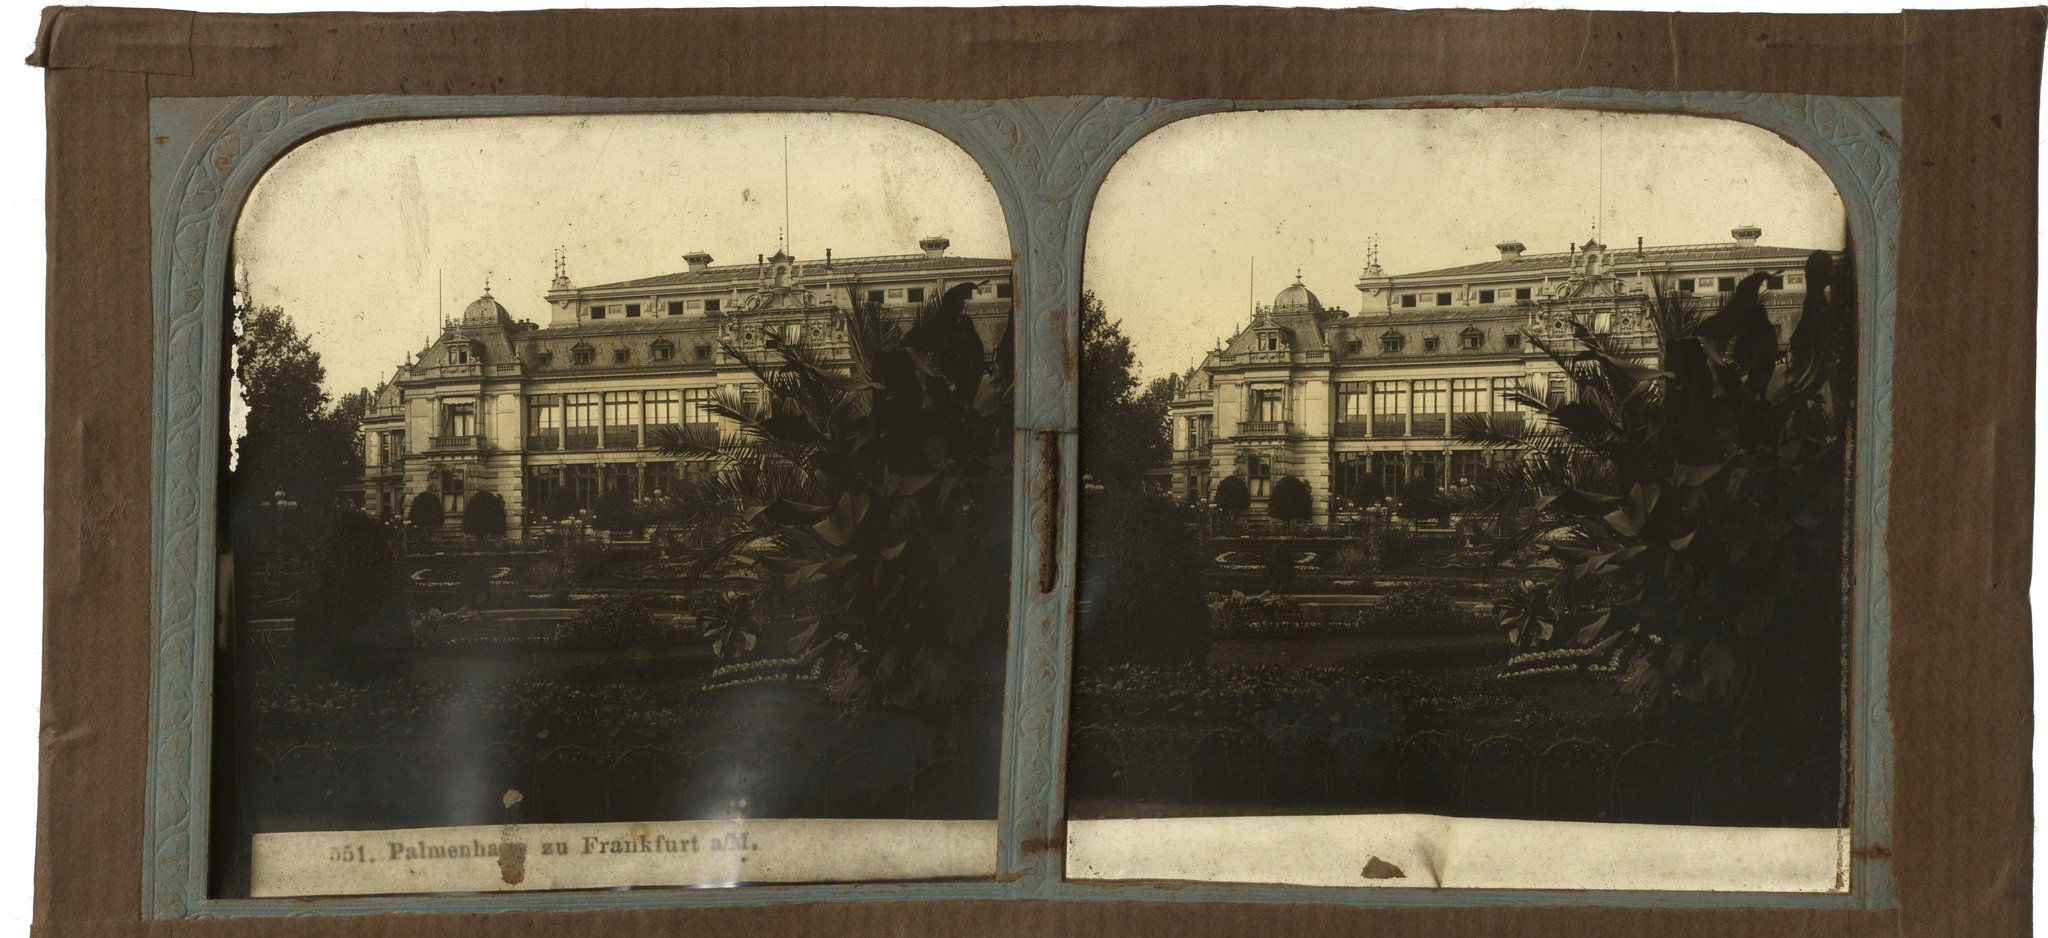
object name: stereograph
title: Palmenhaus zu Frankfurt a/M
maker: Anonymous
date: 1900-1940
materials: cardboard, film, metal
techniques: gelatin silver print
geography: frankfurt am main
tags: botanic garden, 'hortus botanicus'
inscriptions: number: ‘551.’